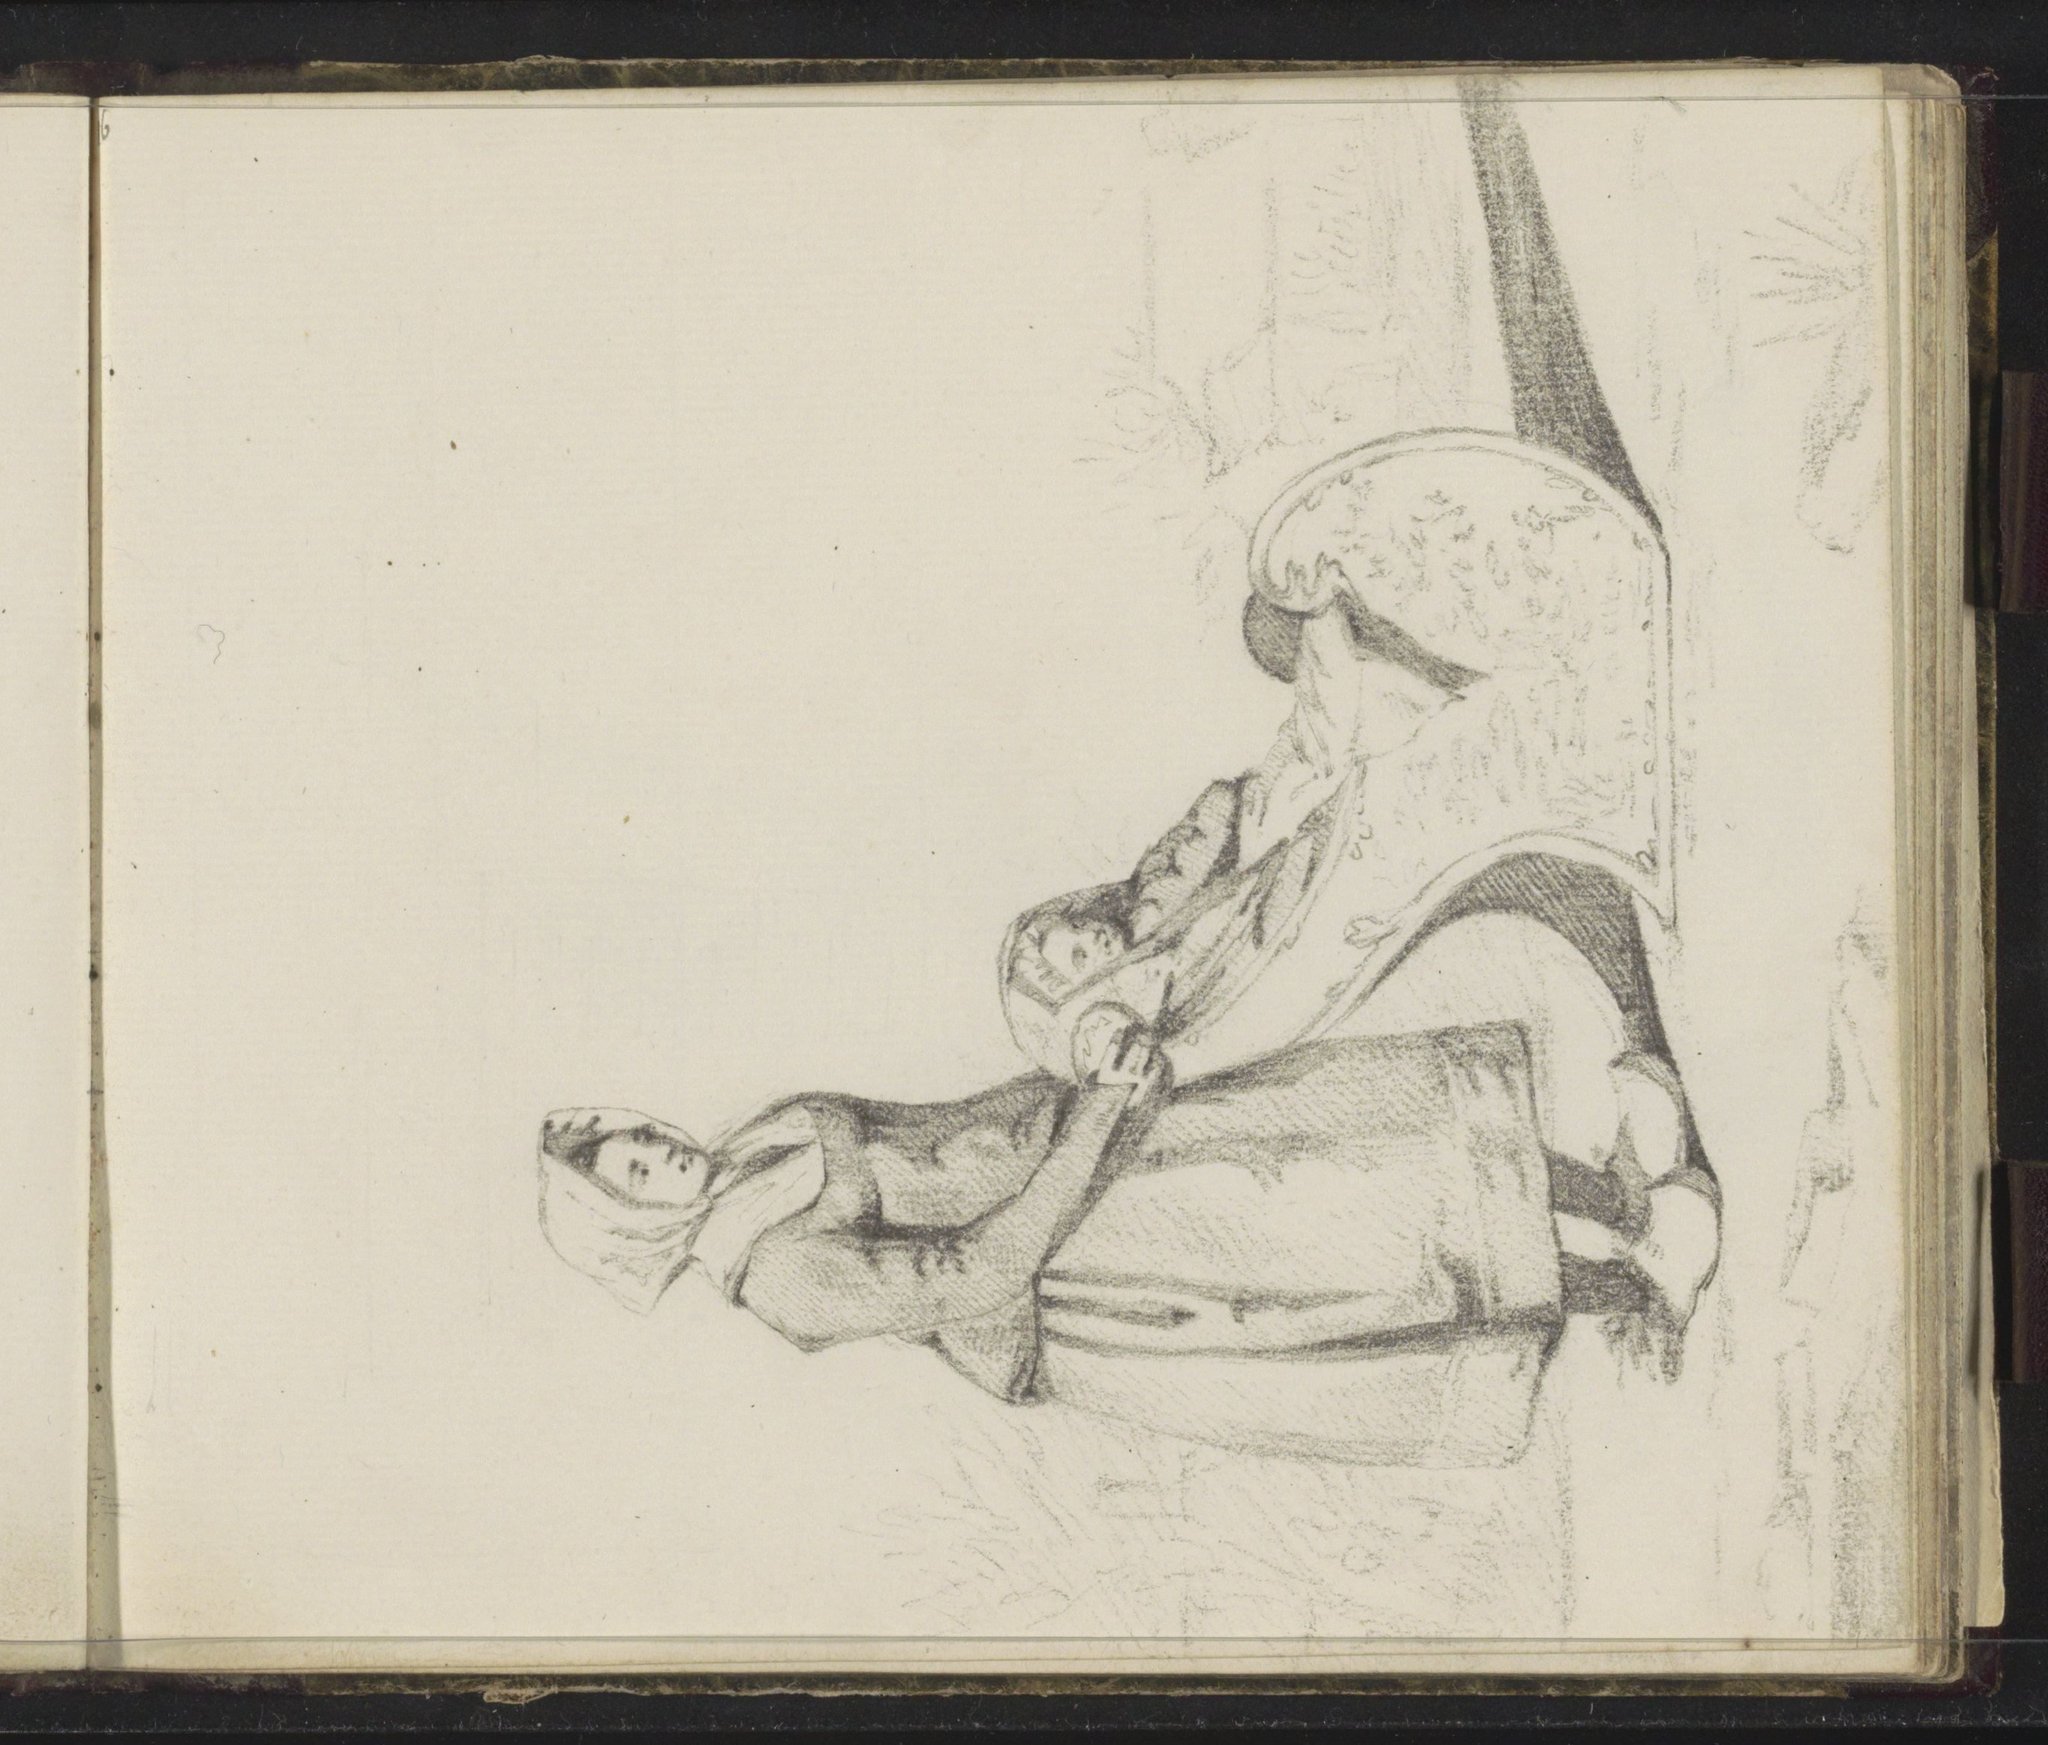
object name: sketchbook leaf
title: Vrouw met een kind in een slede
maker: hendrik abraham klinkhamer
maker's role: draughtsman, painter, print maker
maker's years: 1810-1872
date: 1820-1872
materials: chalk, paper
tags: sleigh, sledge (non-sport), landscapes (+ landscape with figures, staffage)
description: Blad 16 recto uit een schetsboek met 39 bladen.